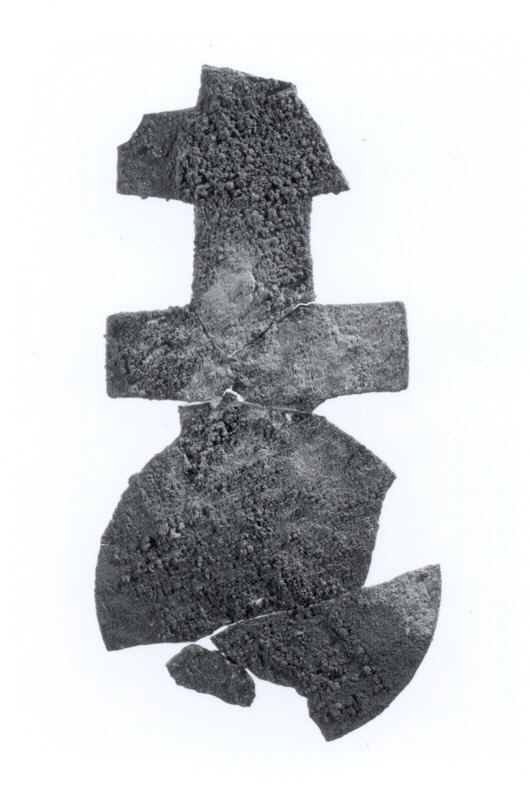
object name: harness or bridle fitting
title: Harness or bridle ornament or fitting (?)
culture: iranian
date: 900-801 BCE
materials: bronze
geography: iran